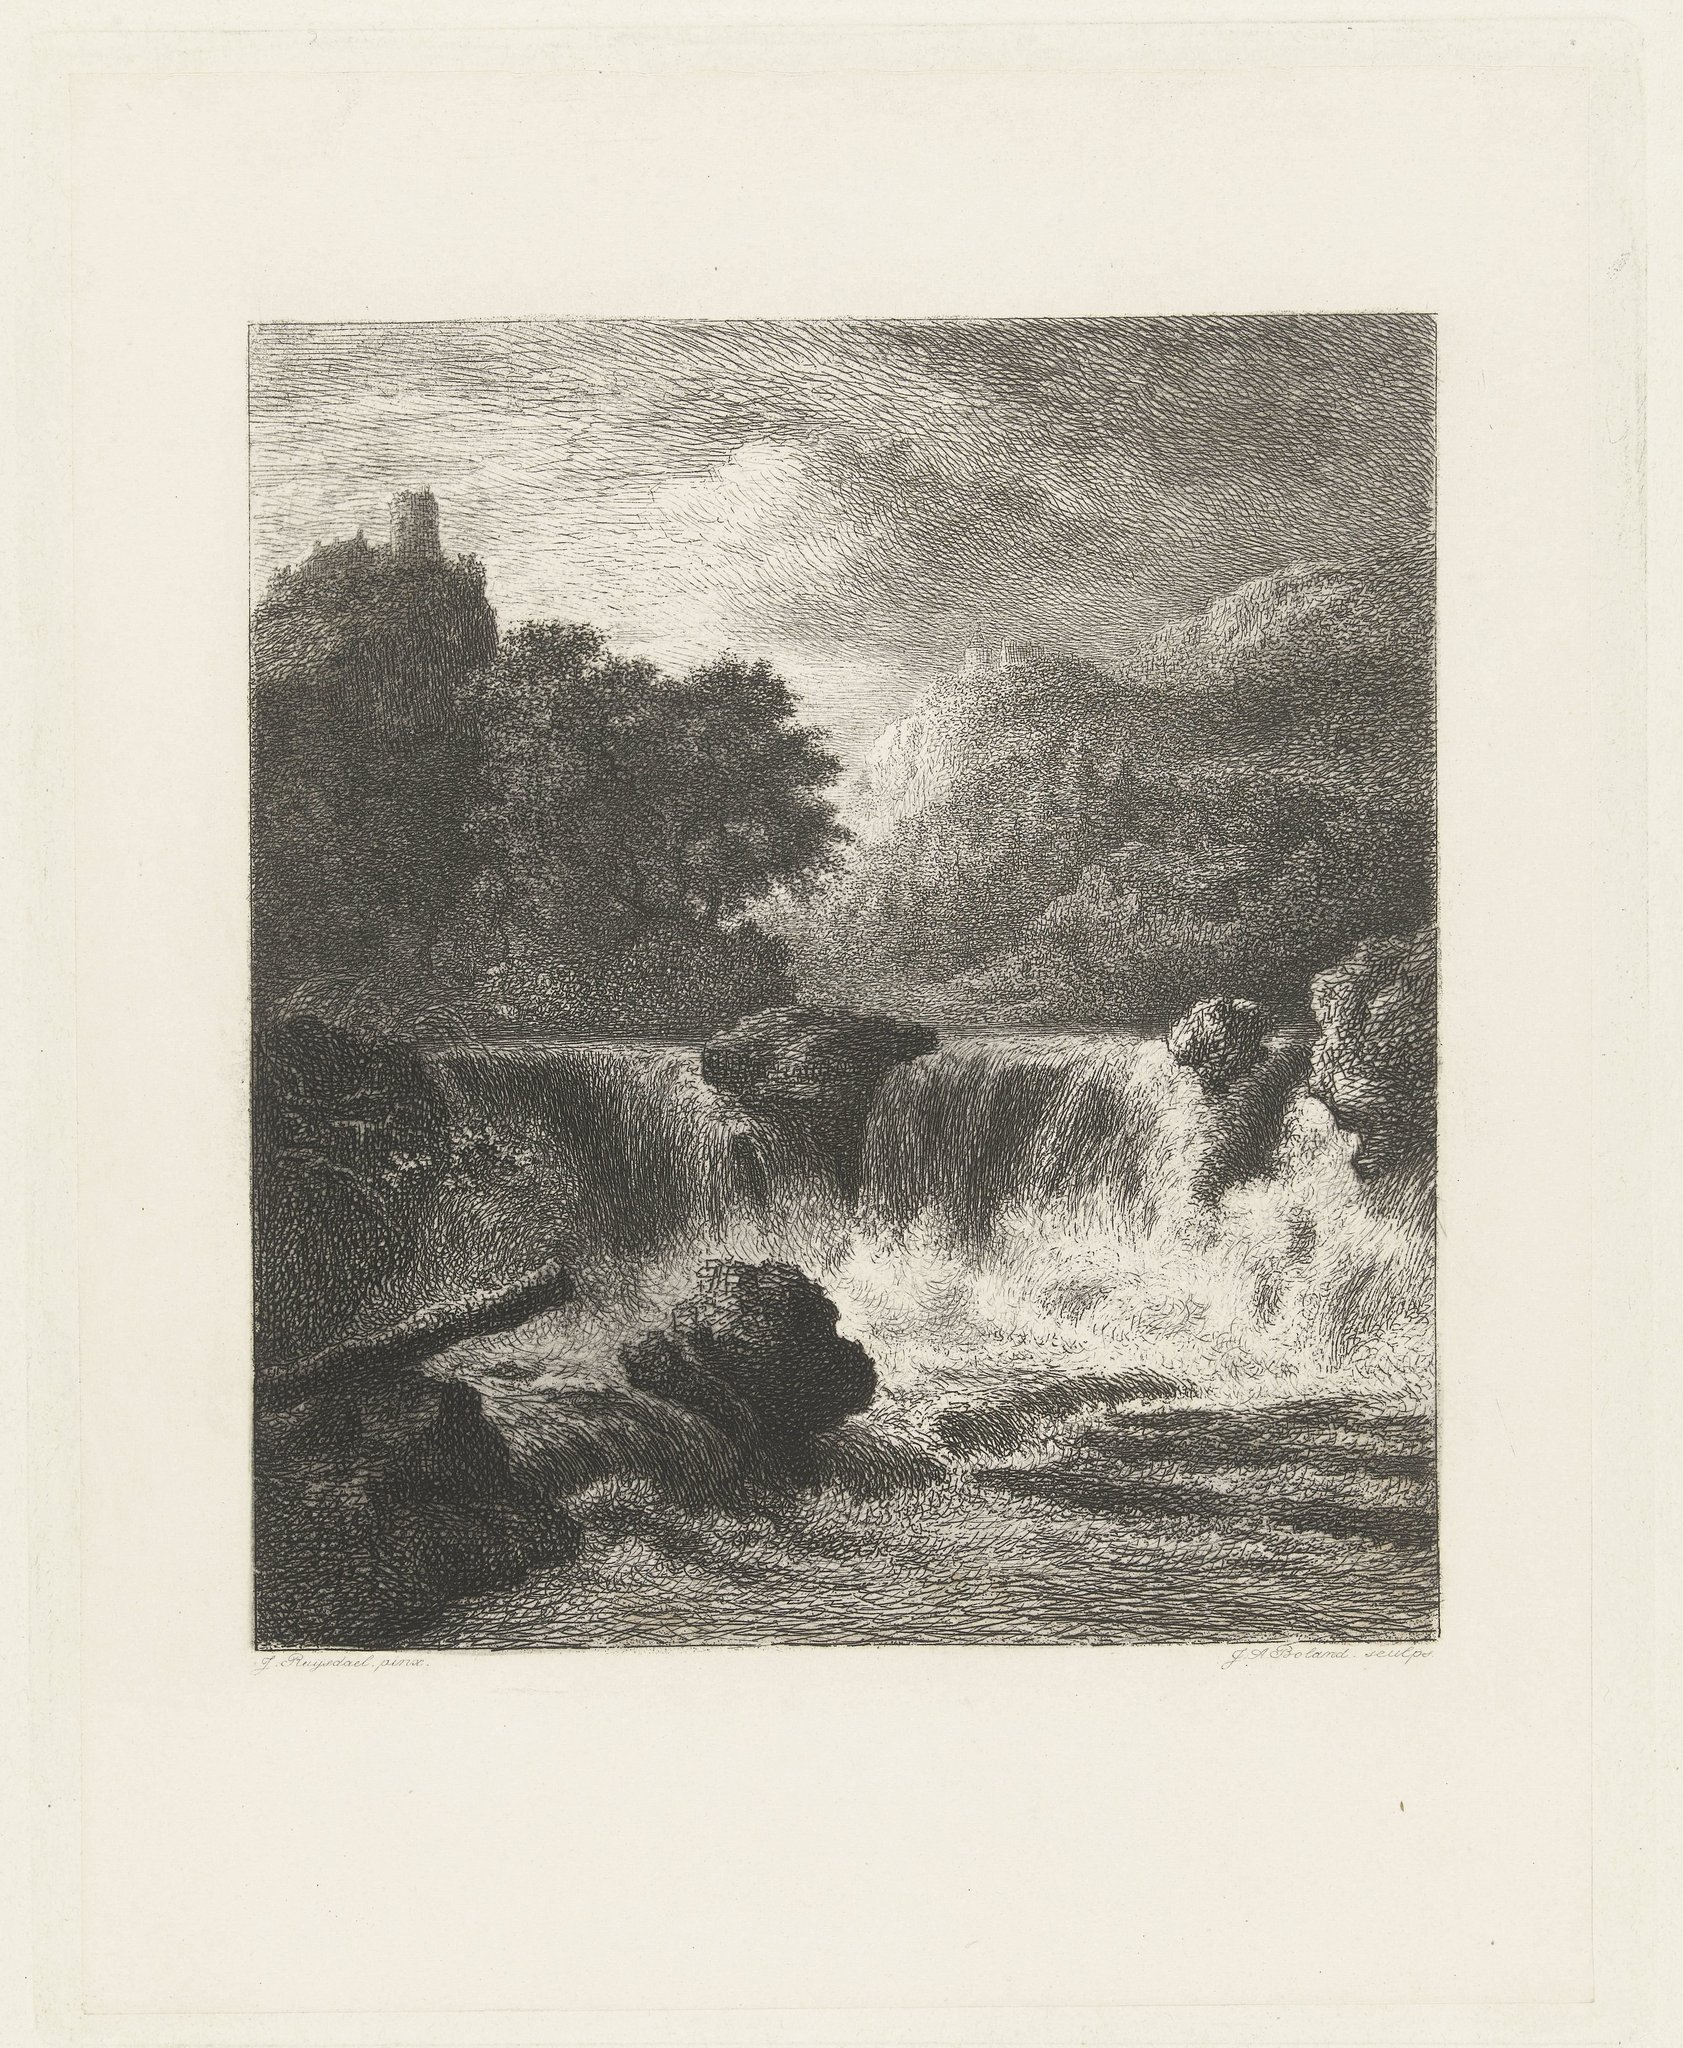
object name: print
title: Berglandschap met waterval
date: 1875-1876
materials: paper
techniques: etching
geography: amsterdam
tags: waterfall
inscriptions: collector's mark: Lugt 2228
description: Reproductie van een schilderij uit de collectie van het Rijksmuseum Amsterdam, SK-A-348. Prent afkomstig uit: Brink, J. ten (et al.). Het Rijksmuseum te Amsterdam: [25] etsen van J.A. Boland. Haarlem: J.M. Schalekamp, [1875-1876] (13 A 20).